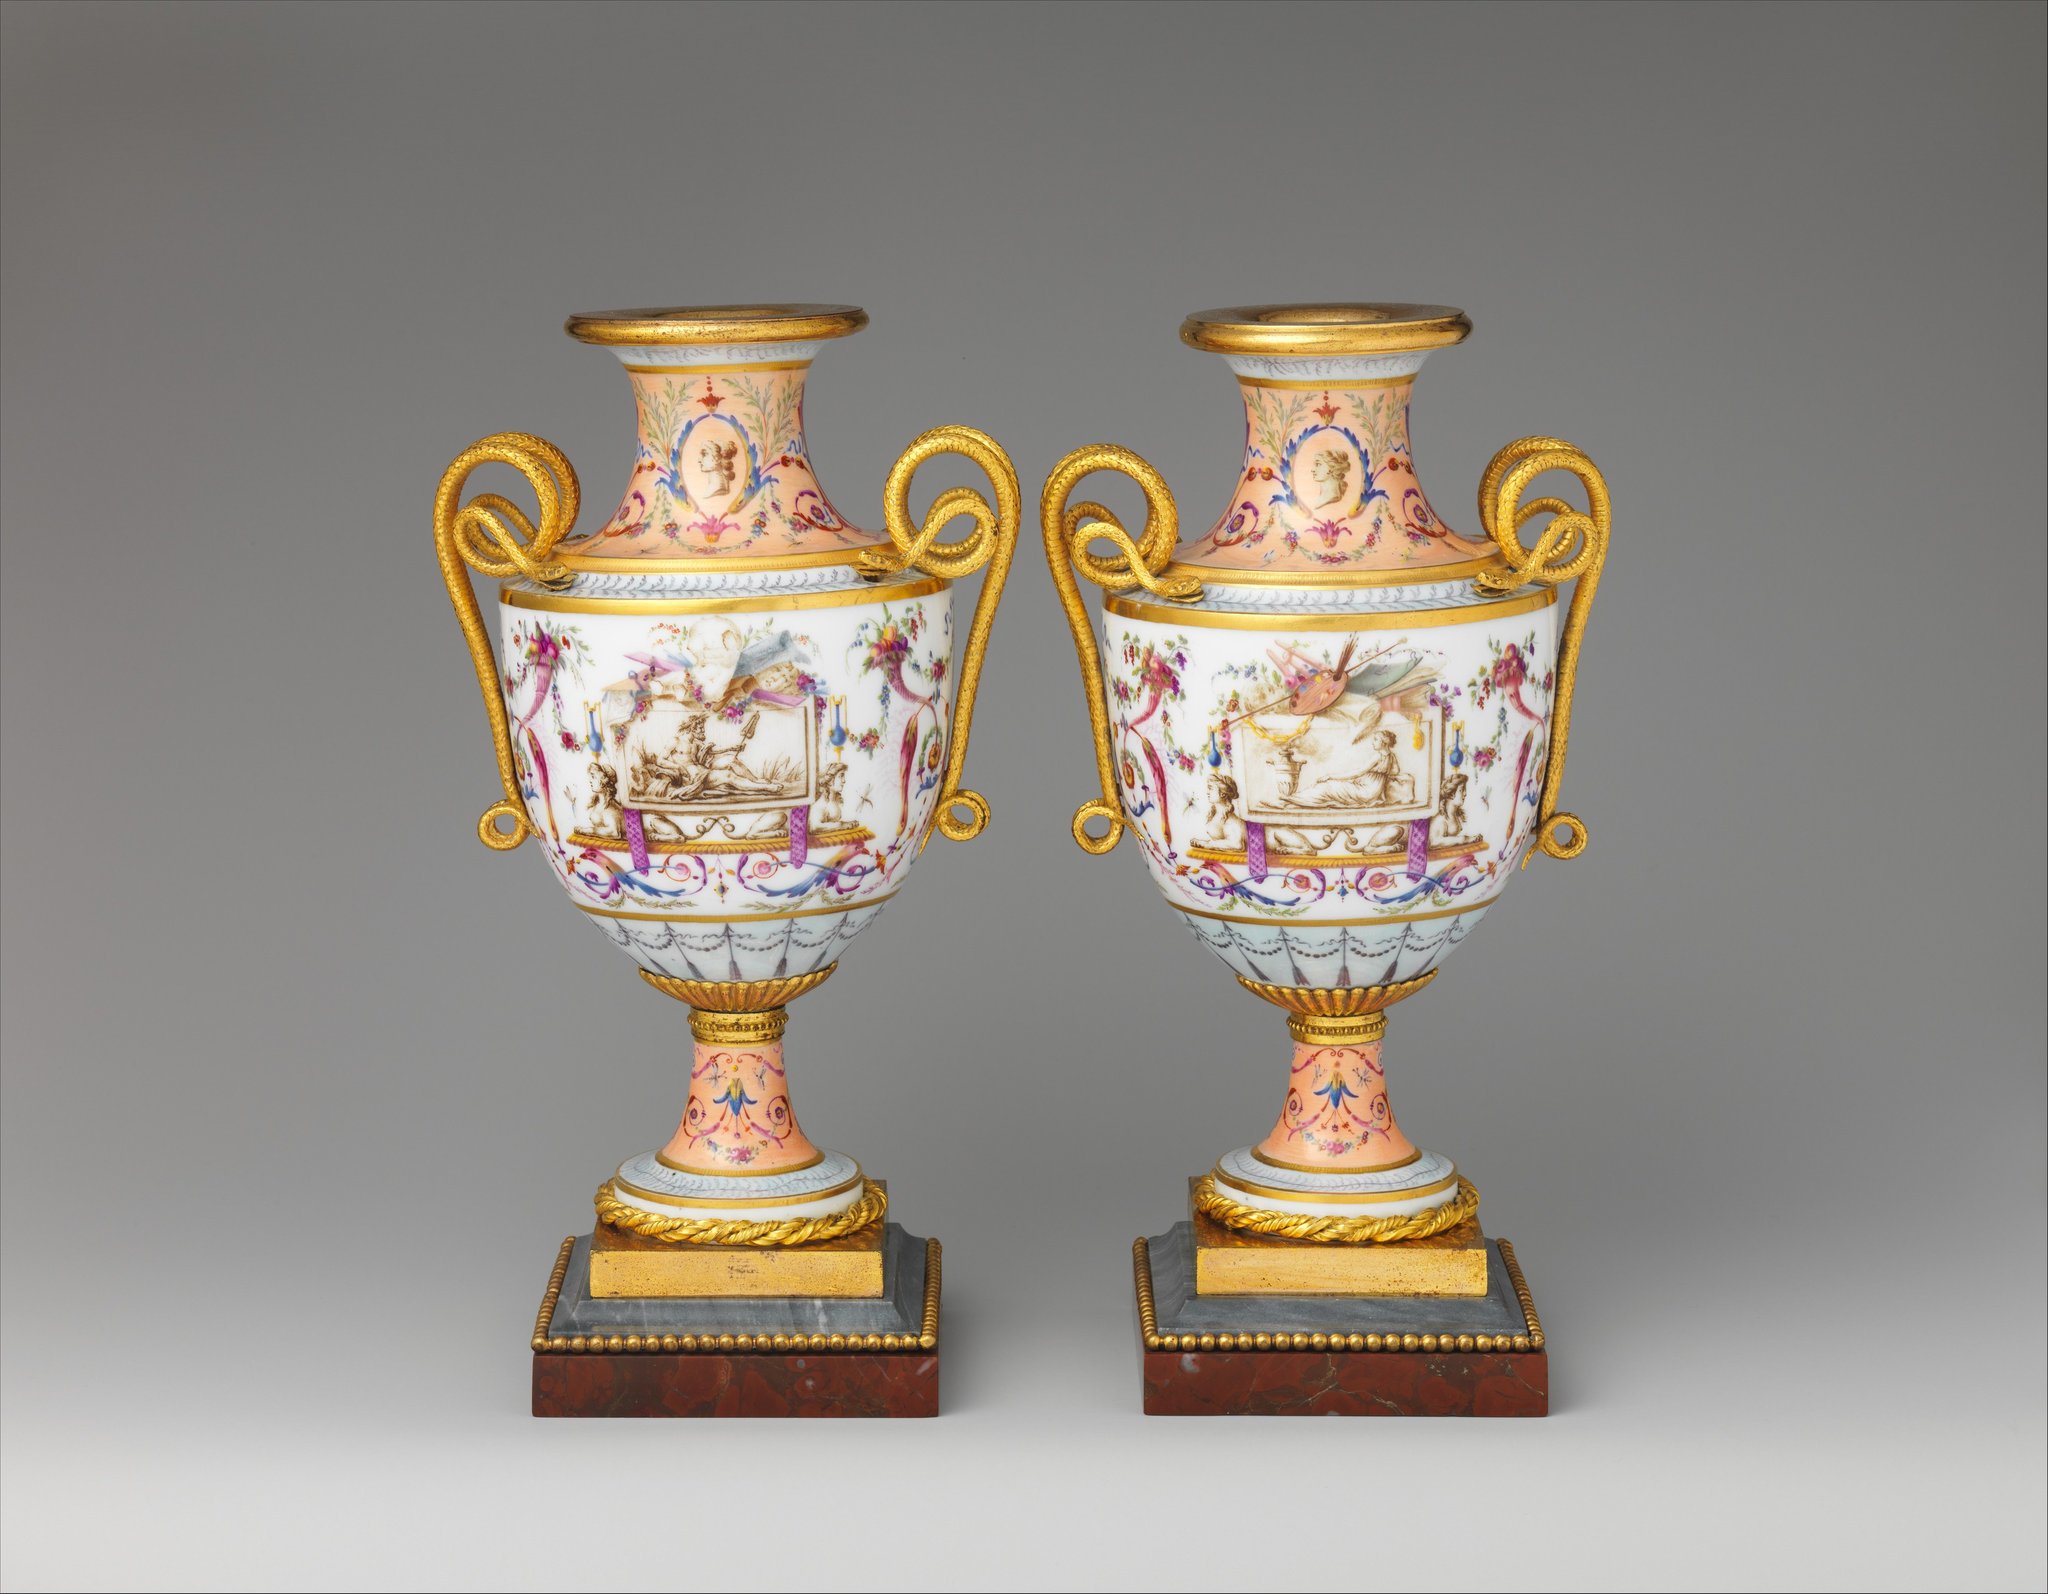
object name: vase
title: Pair of vases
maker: sèvres manufactory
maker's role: manufactory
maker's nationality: french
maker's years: 1740-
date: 1789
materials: gilt bronze, hard paste porcelain, marble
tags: flowers